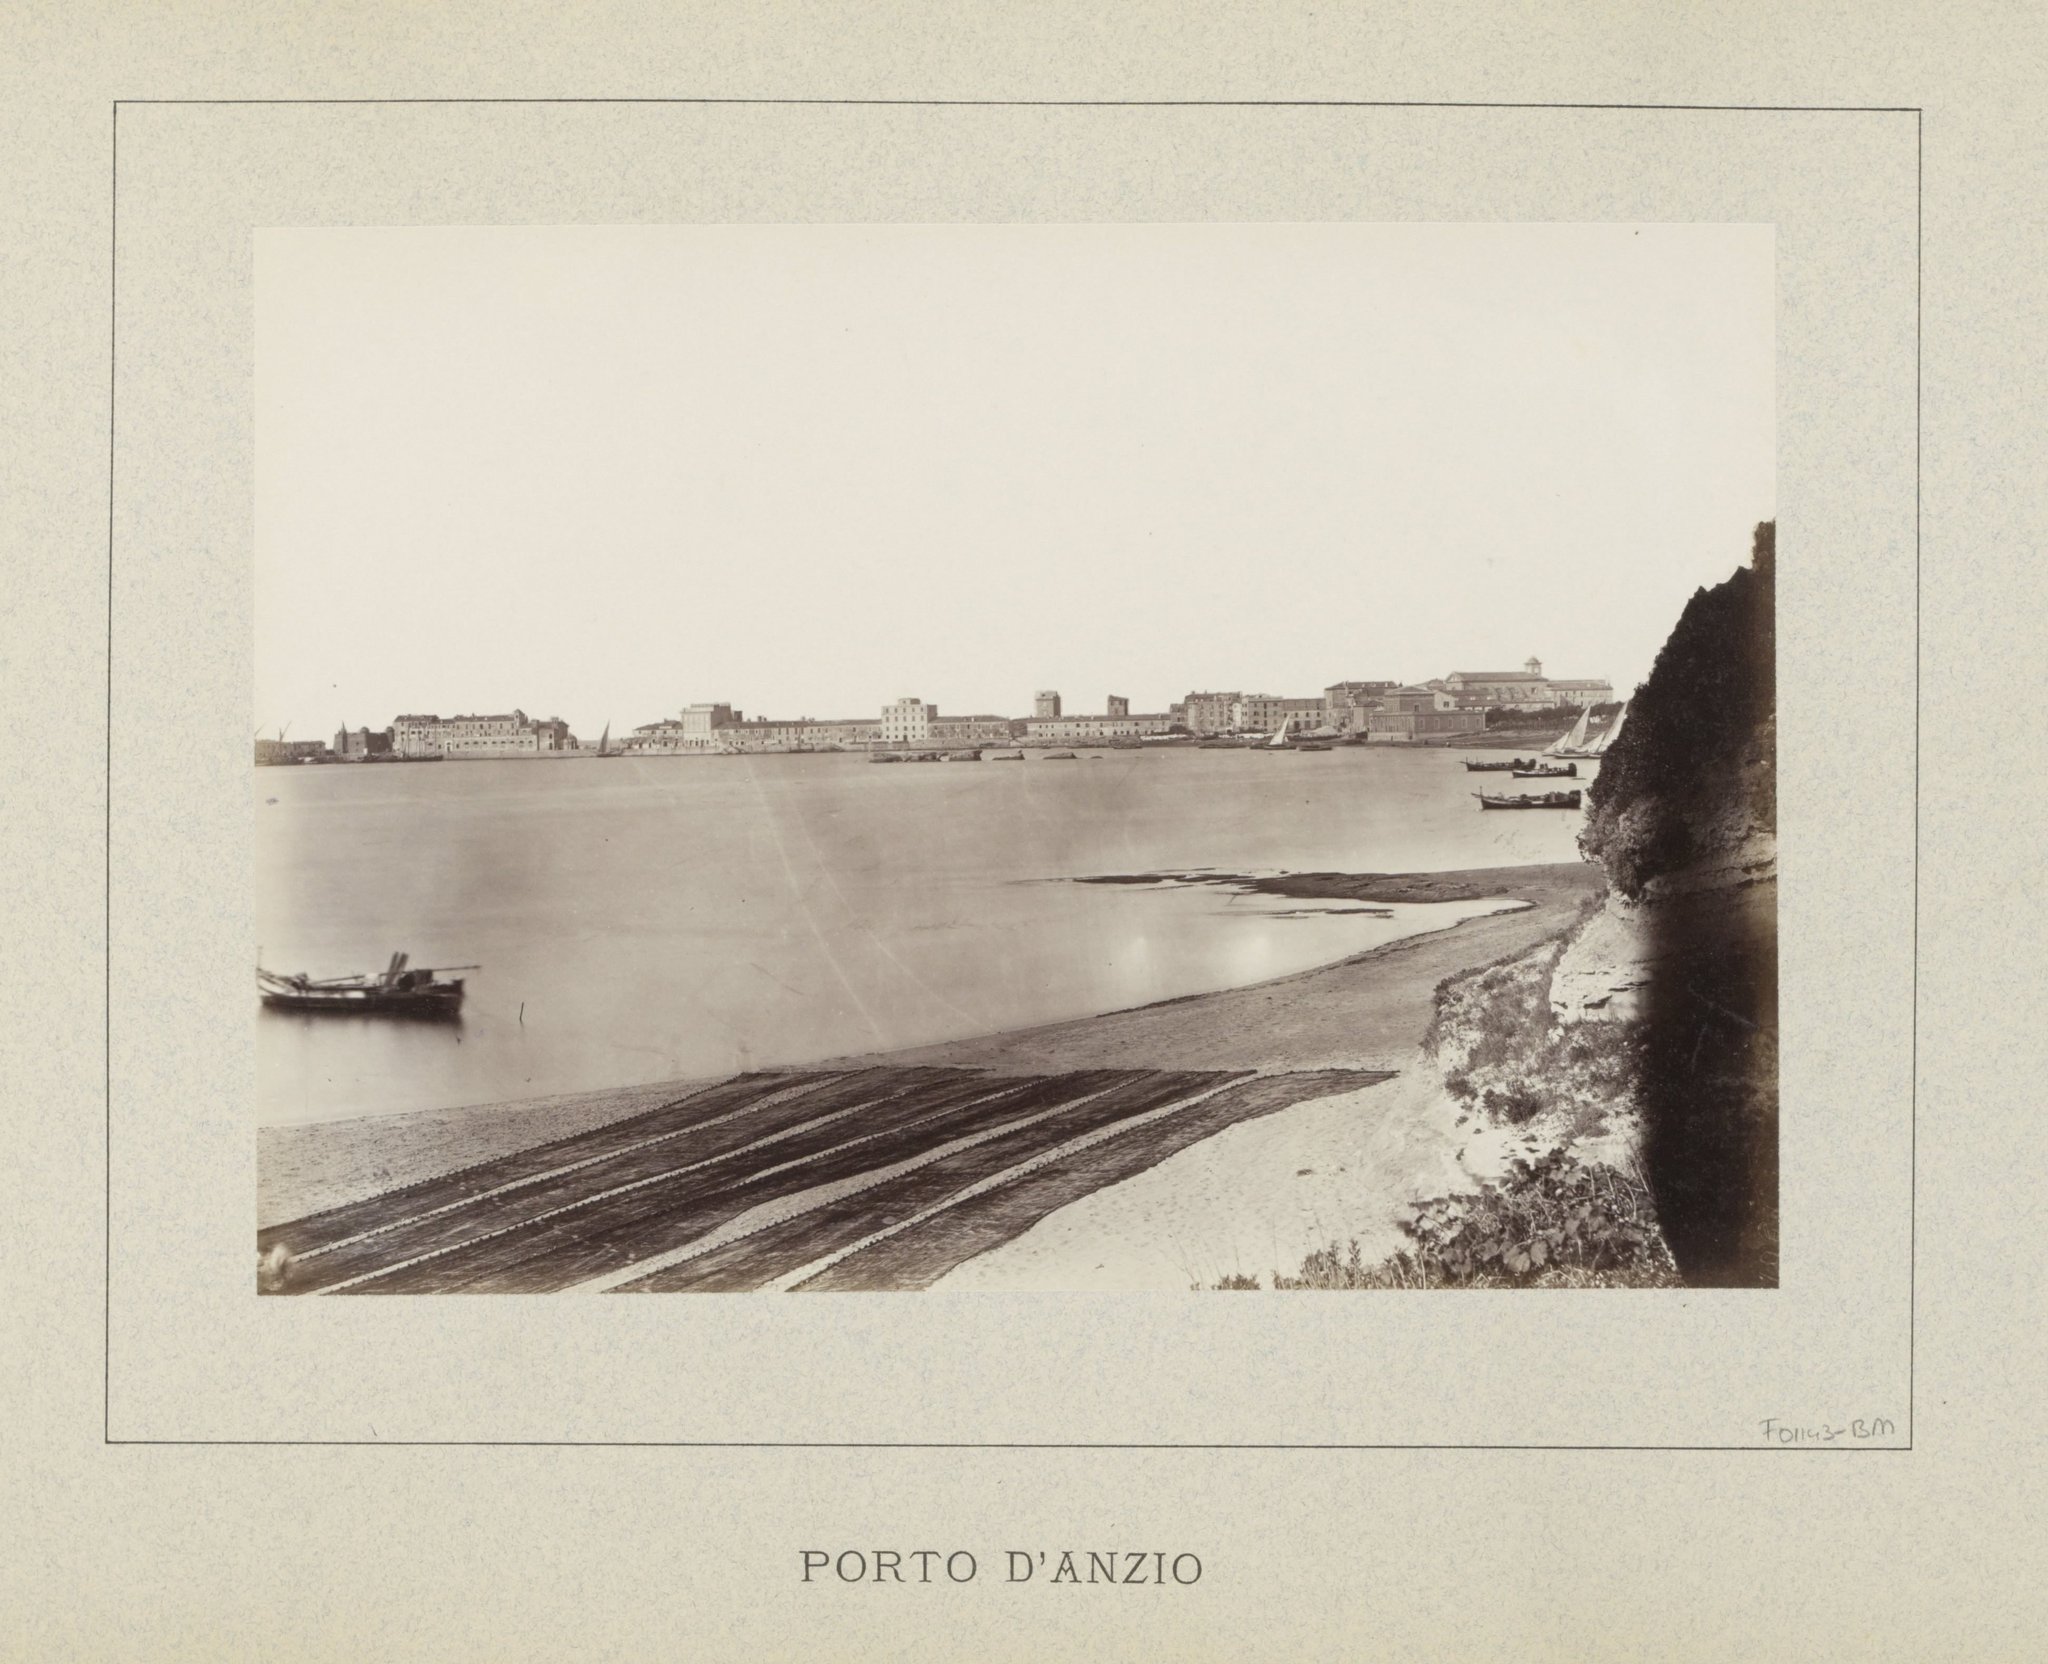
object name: photograph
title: Gezicht op Anzio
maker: Anonymous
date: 1860-1900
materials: photographic support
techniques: albumen print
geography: anzio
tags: prospect of village, silhouette of village, gulf, bay (+ landscape with figures, staffage), harbour (+ view ~ vehicle, ship, etc.), anzio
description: Onderdeel van Fotoalbum met opnames van bezienswaardigheden en kunstwerken in Rome.